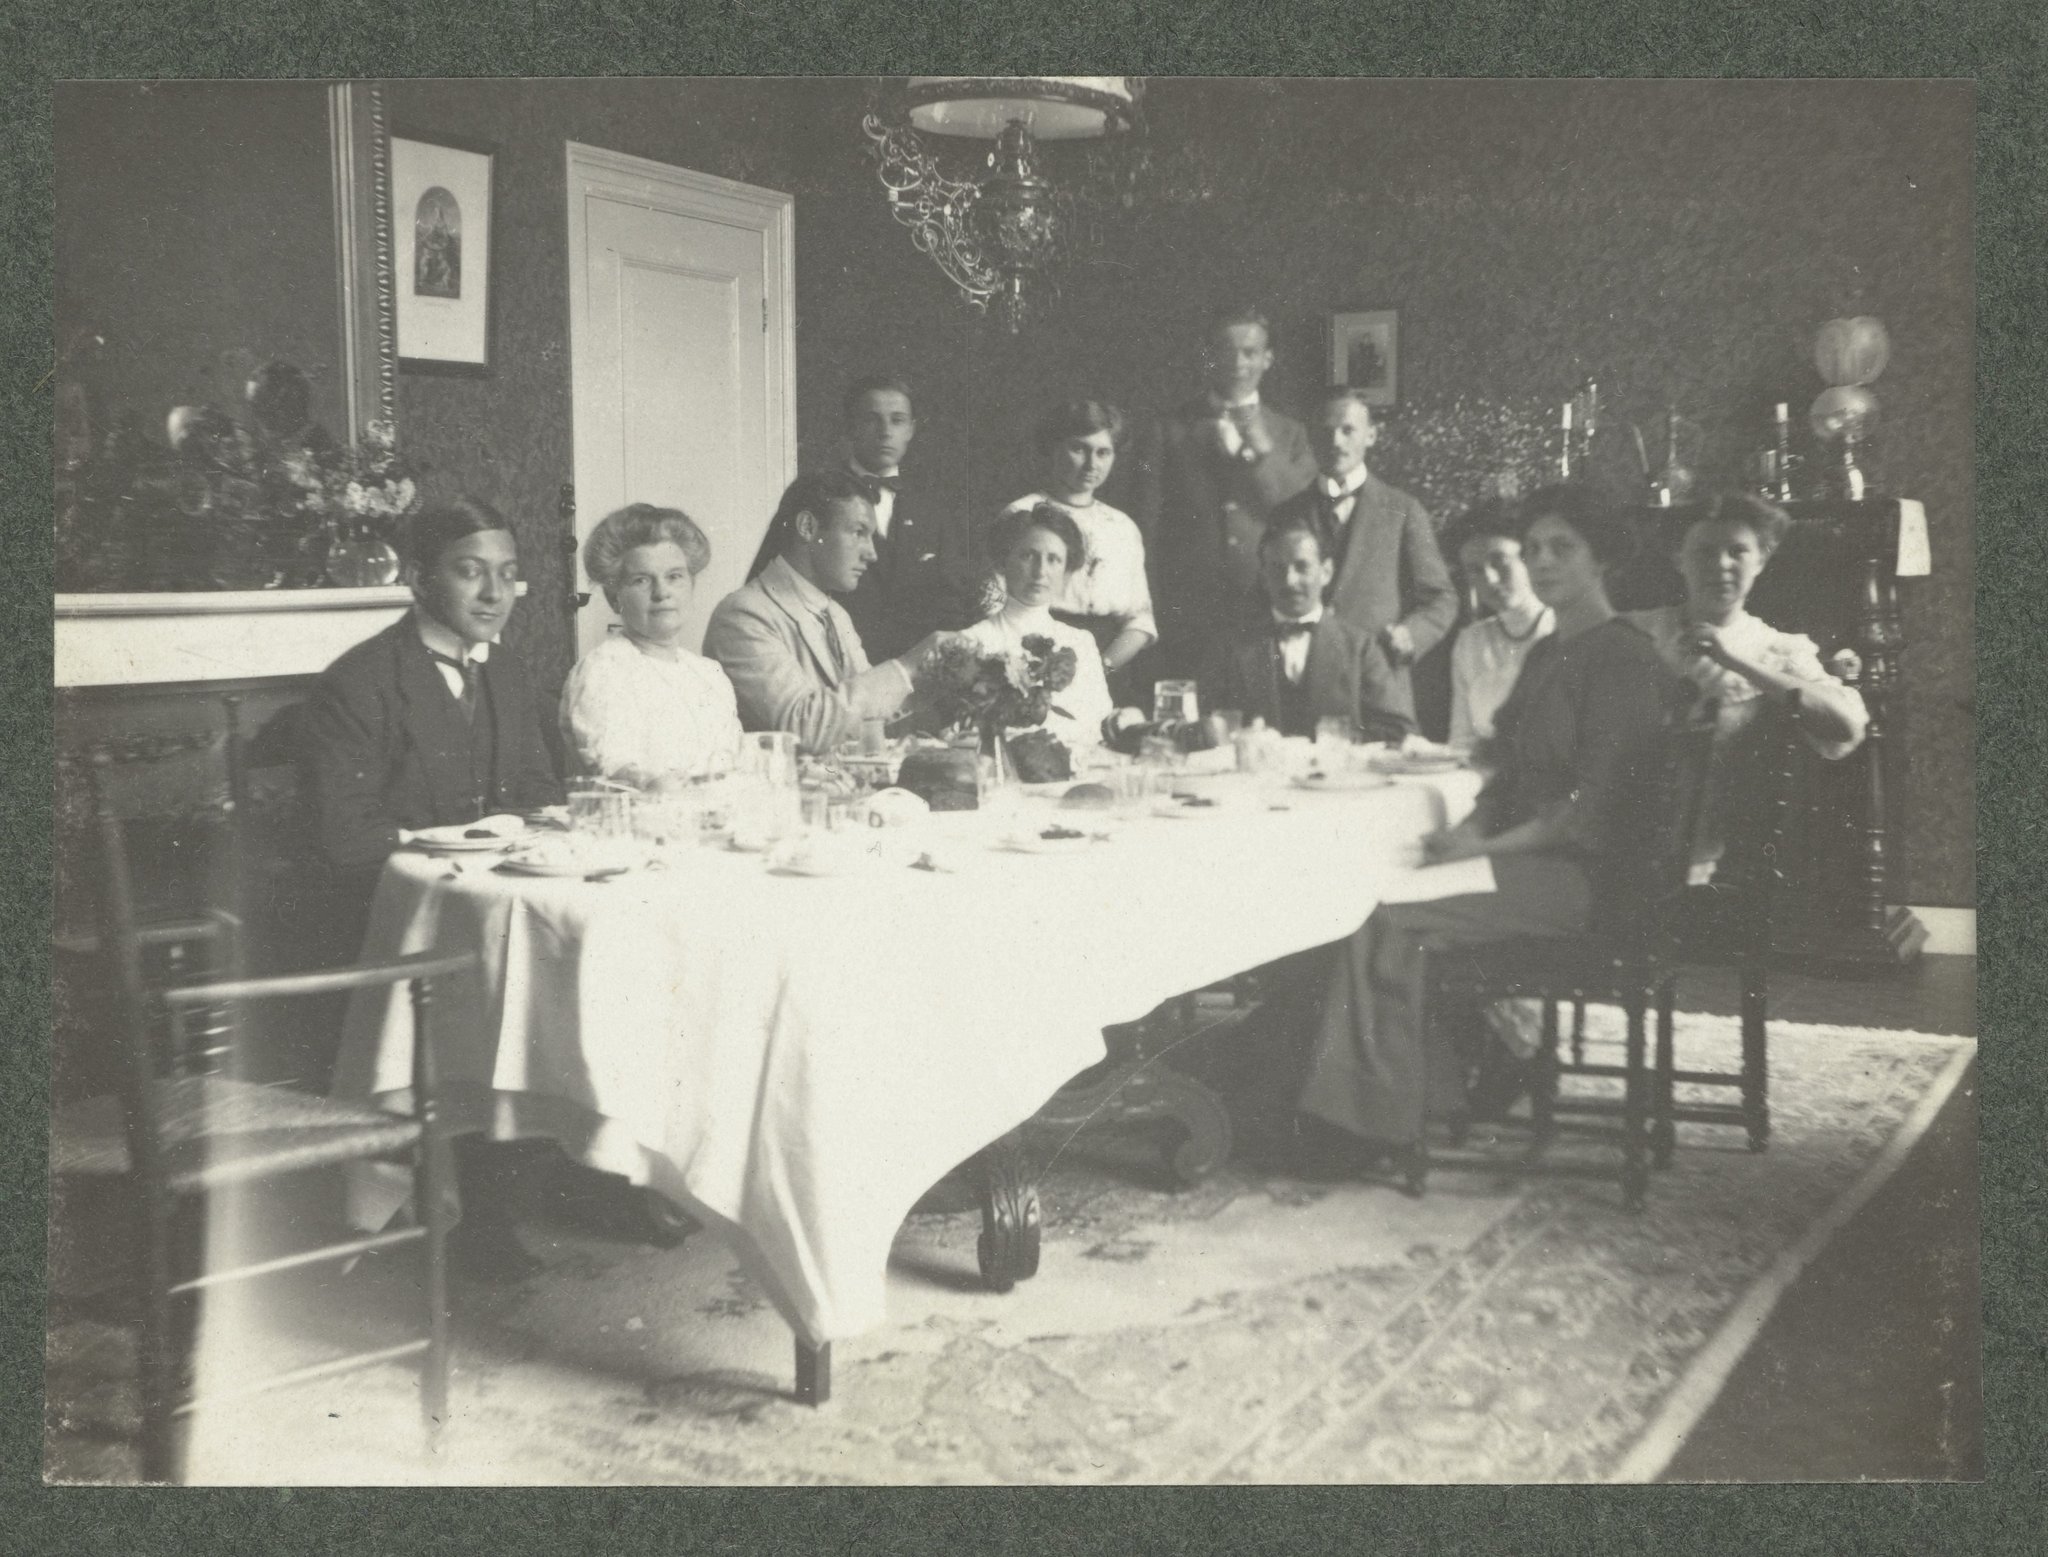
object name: photograph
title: Familie Kessler aan de dinertafel van landgoed Pauw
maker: geldolph adriaan kessler (dolph)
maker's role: fotograaf, industrieel, voetballer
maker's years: 1884-1945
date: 1913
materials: paper, photographic support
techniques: photography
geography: netherlands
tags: goes, digna fransen van de putte, huize de paauw